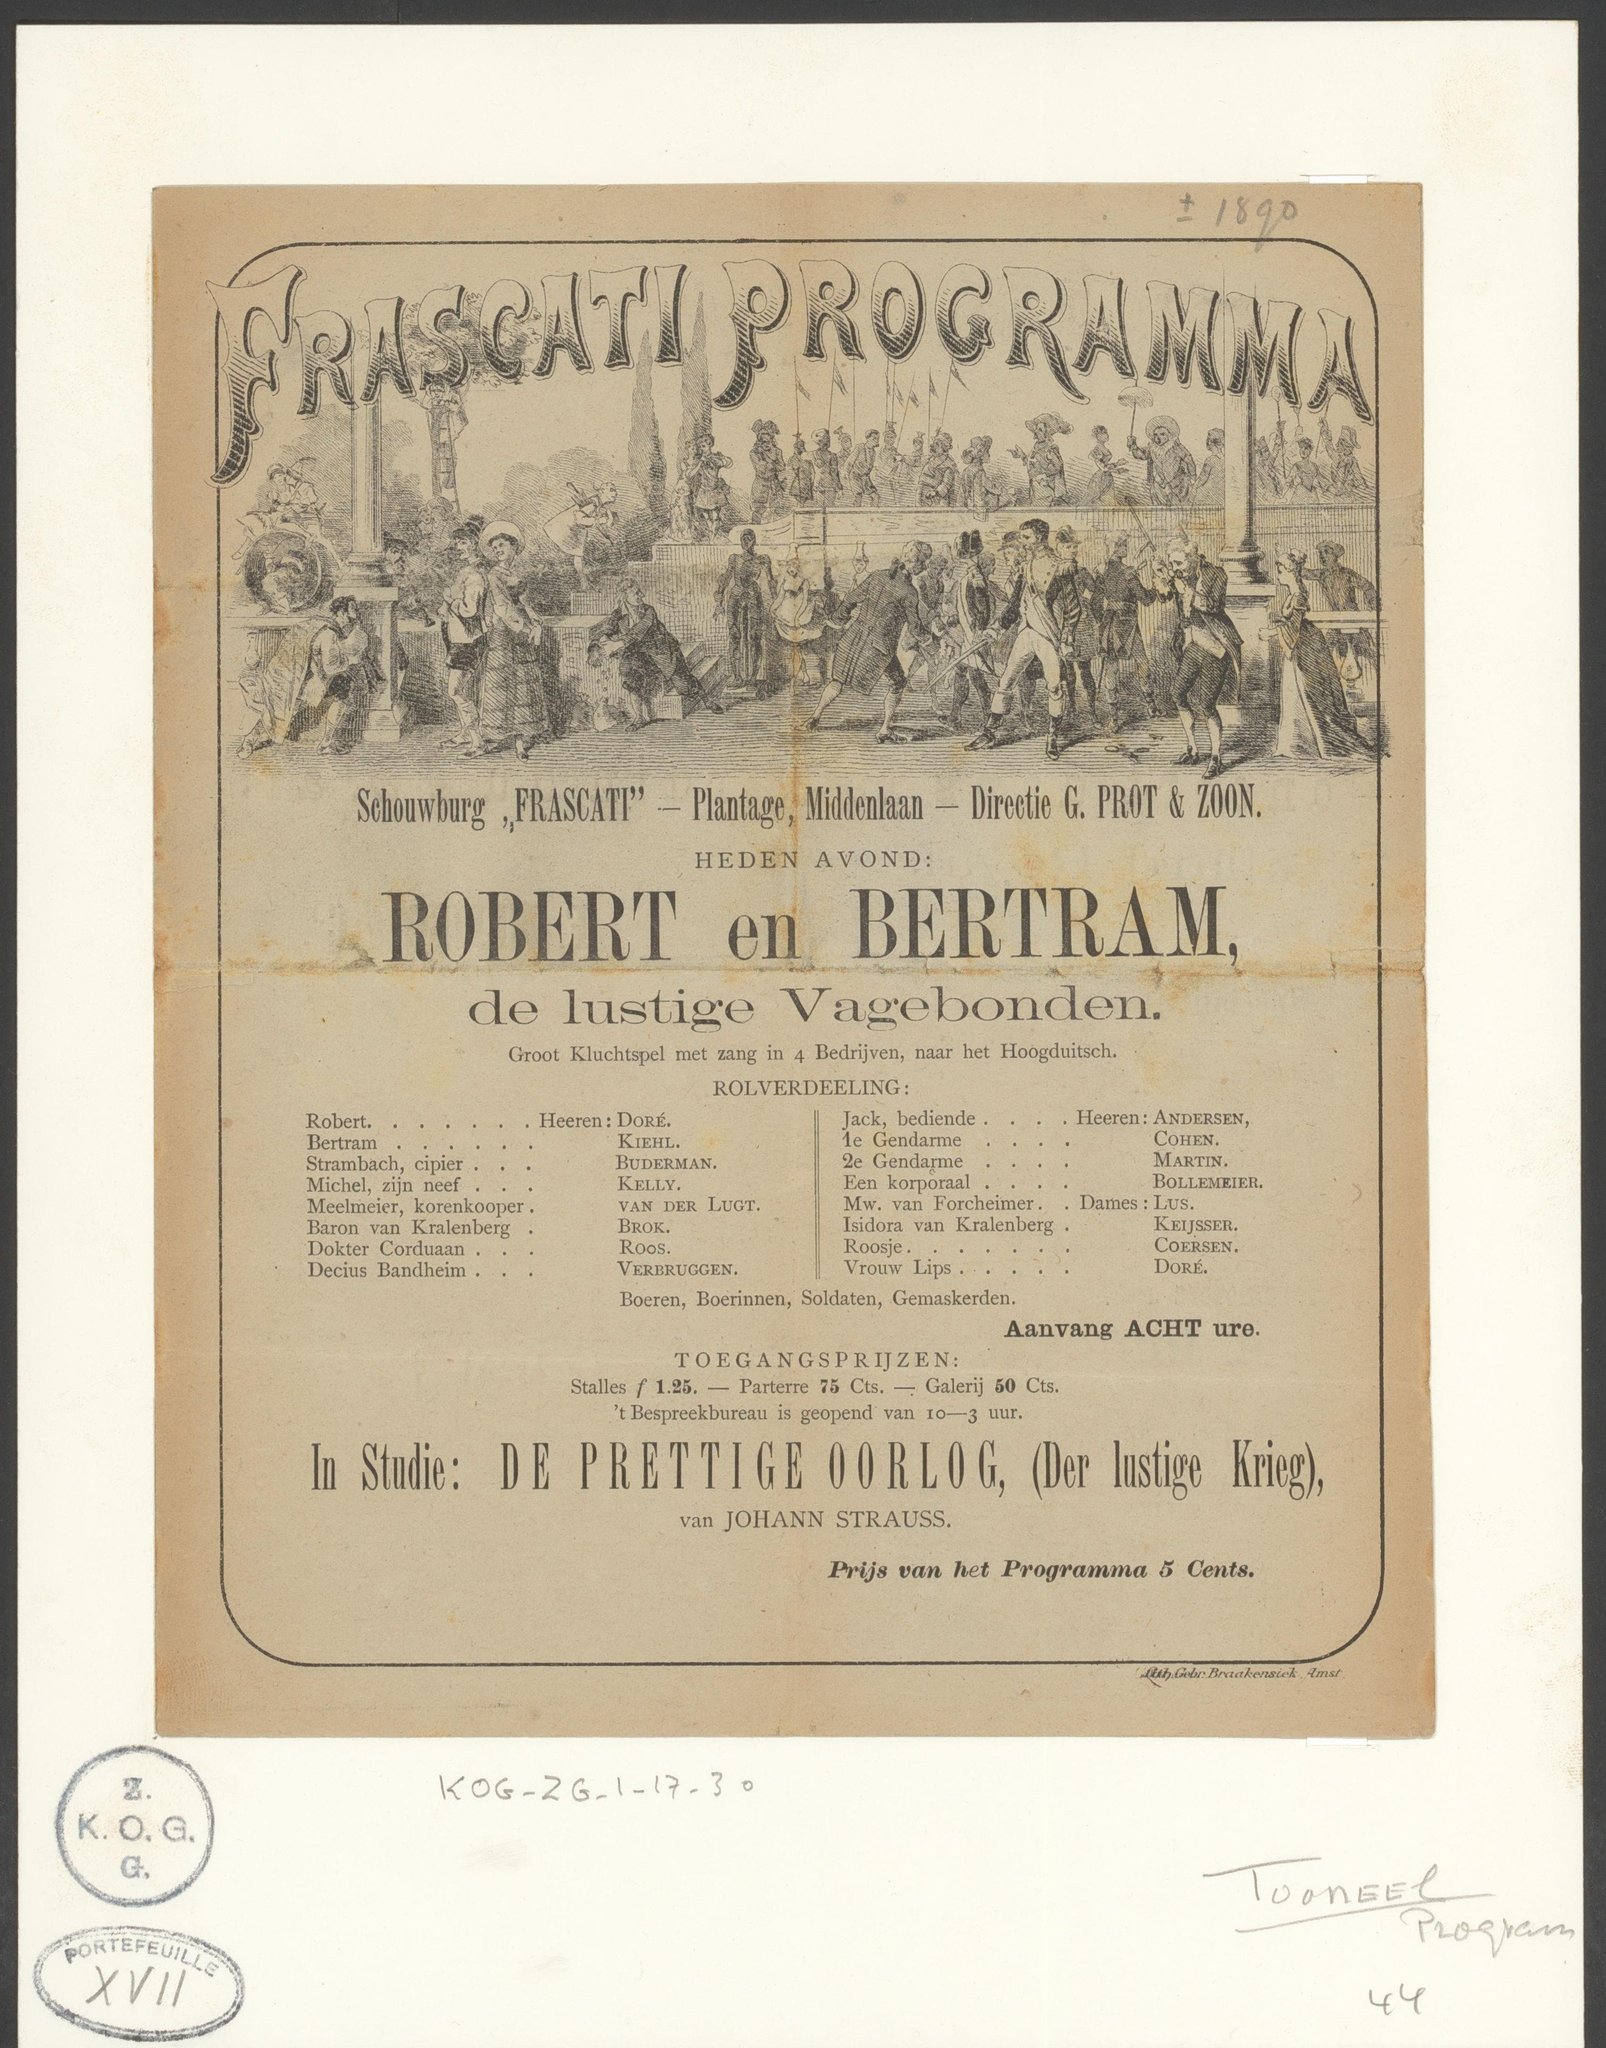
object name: text sheet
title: Frascati programma met de aankondiging voor de voorstelling Robert en Bertram, de lustige Vagebonden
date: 1884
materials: paper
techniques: letterpress printing, lithograph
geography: amsterdam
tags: theatre, theatrical performance, advertisement, notice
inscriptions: stamp, collector's mark: Lugt 1641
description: Een gevouwen blad vormt samen vier pagina's. Op de eerste pagina een aankondiging voor de voorstelling Robert en Bertram, de lustige Vagebonden in schouwburg Frascati. Op de overige pagina's diverse advertenties. Onderwerpsrubrieken binnen de Atlas Zeden en Gewoonten: Tooneel, Toneelprogramma’s.